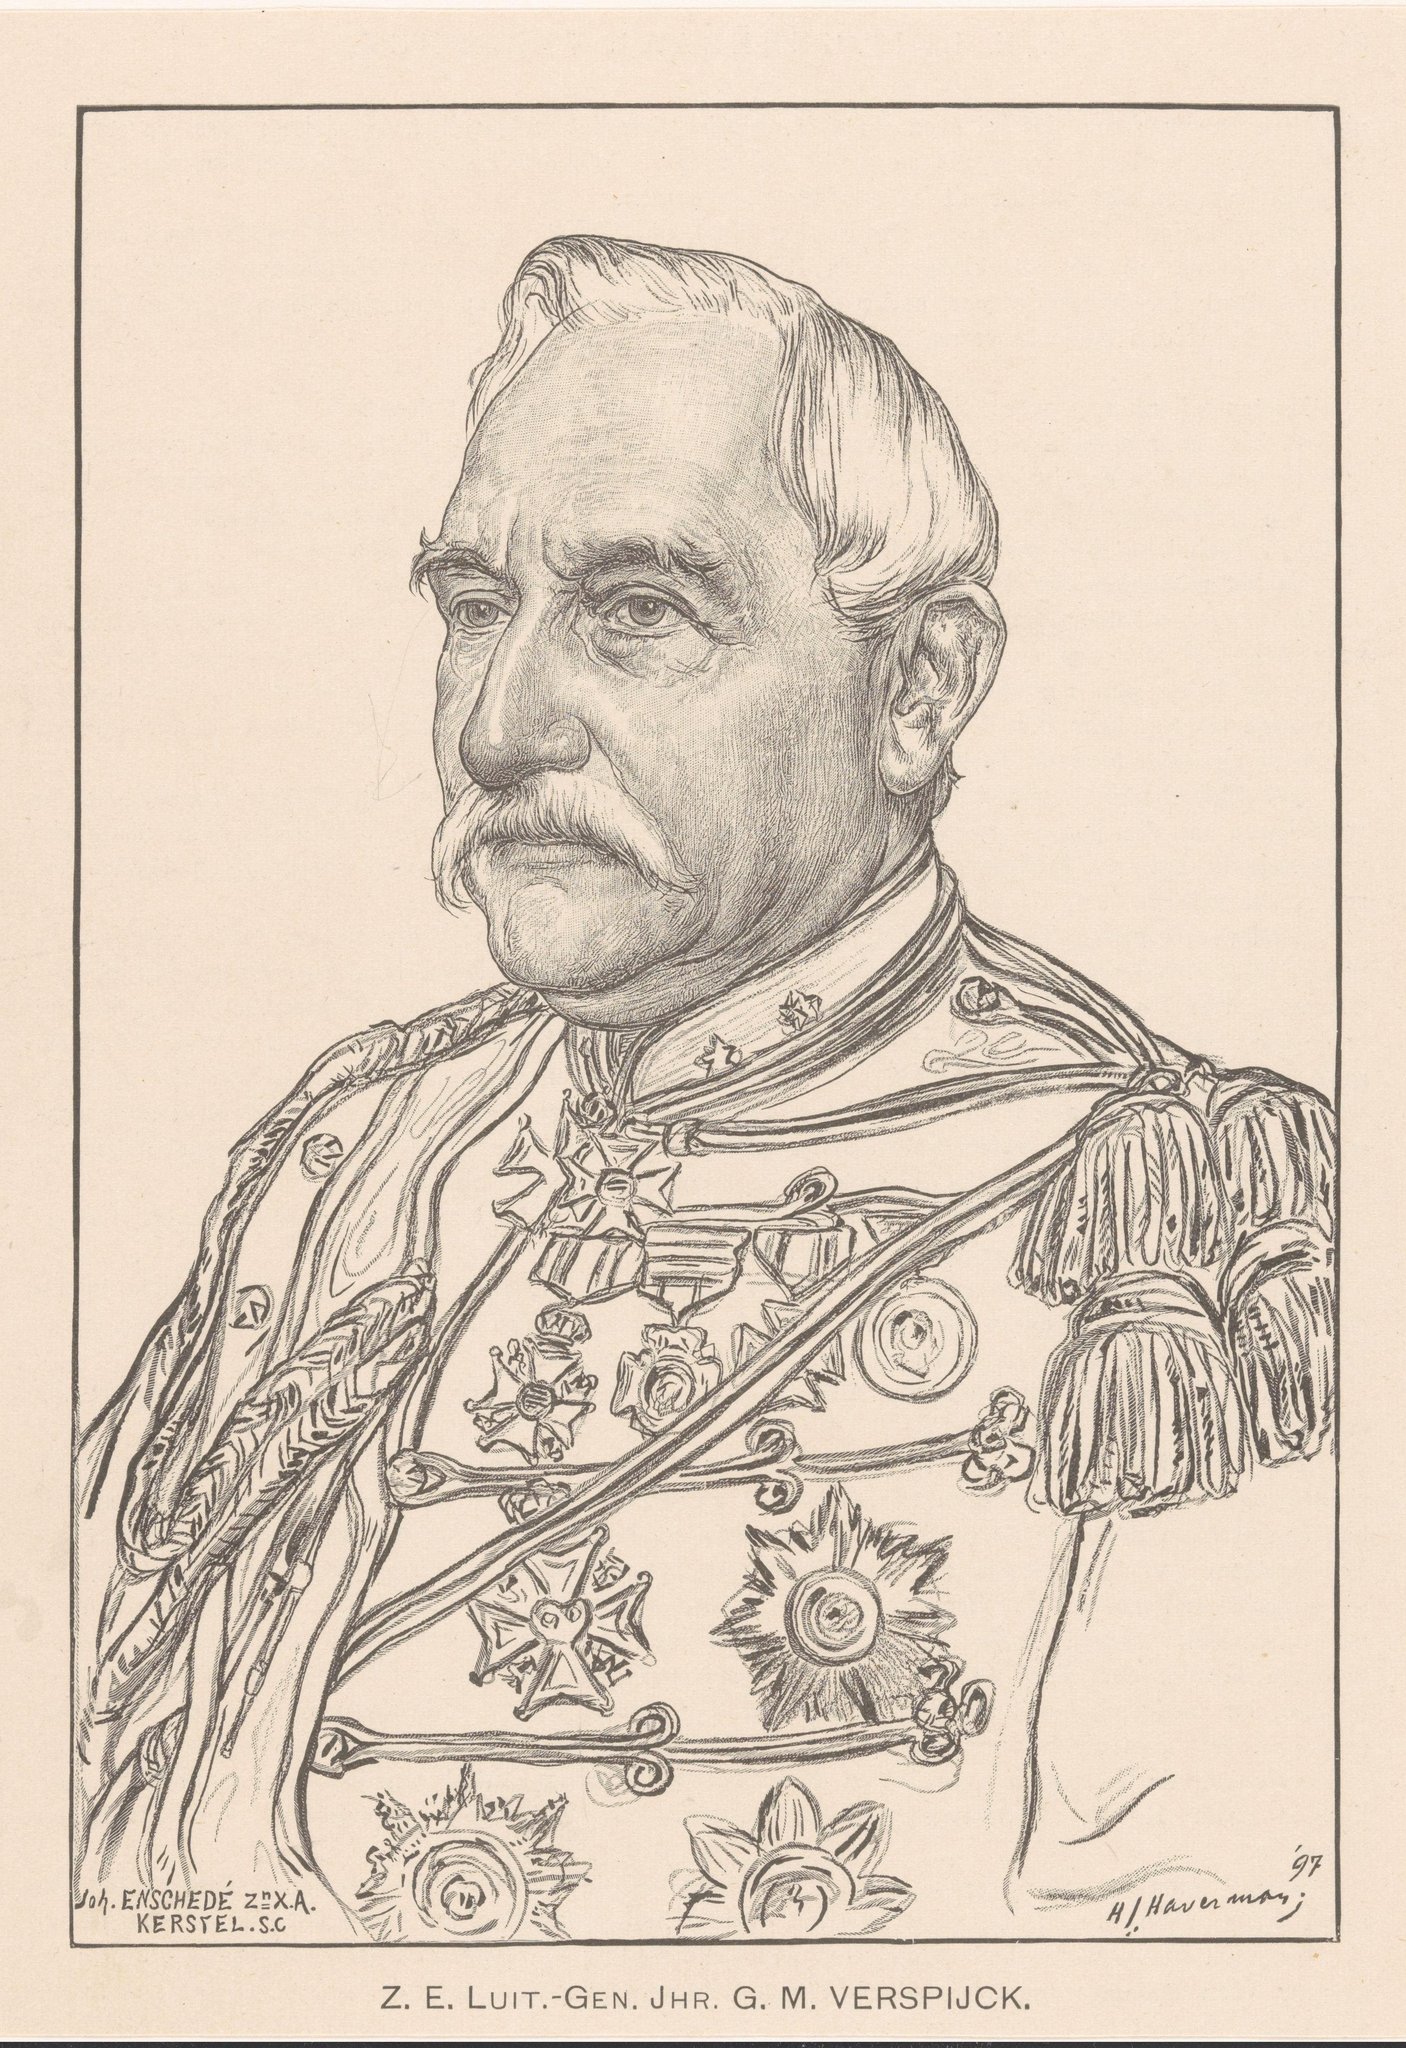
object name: print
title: Portret van Gustave Marie Verspyck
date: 1897-1936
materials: paper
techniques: lithograph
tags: ghent, the hague, historical persons, (military) uniforms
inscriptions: collector's mark: Lugt 2228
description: Een portret van publicist en militair Gustave Maria Verspyck, gekleed in een uniform met daarop verschillende onderscheidingen.